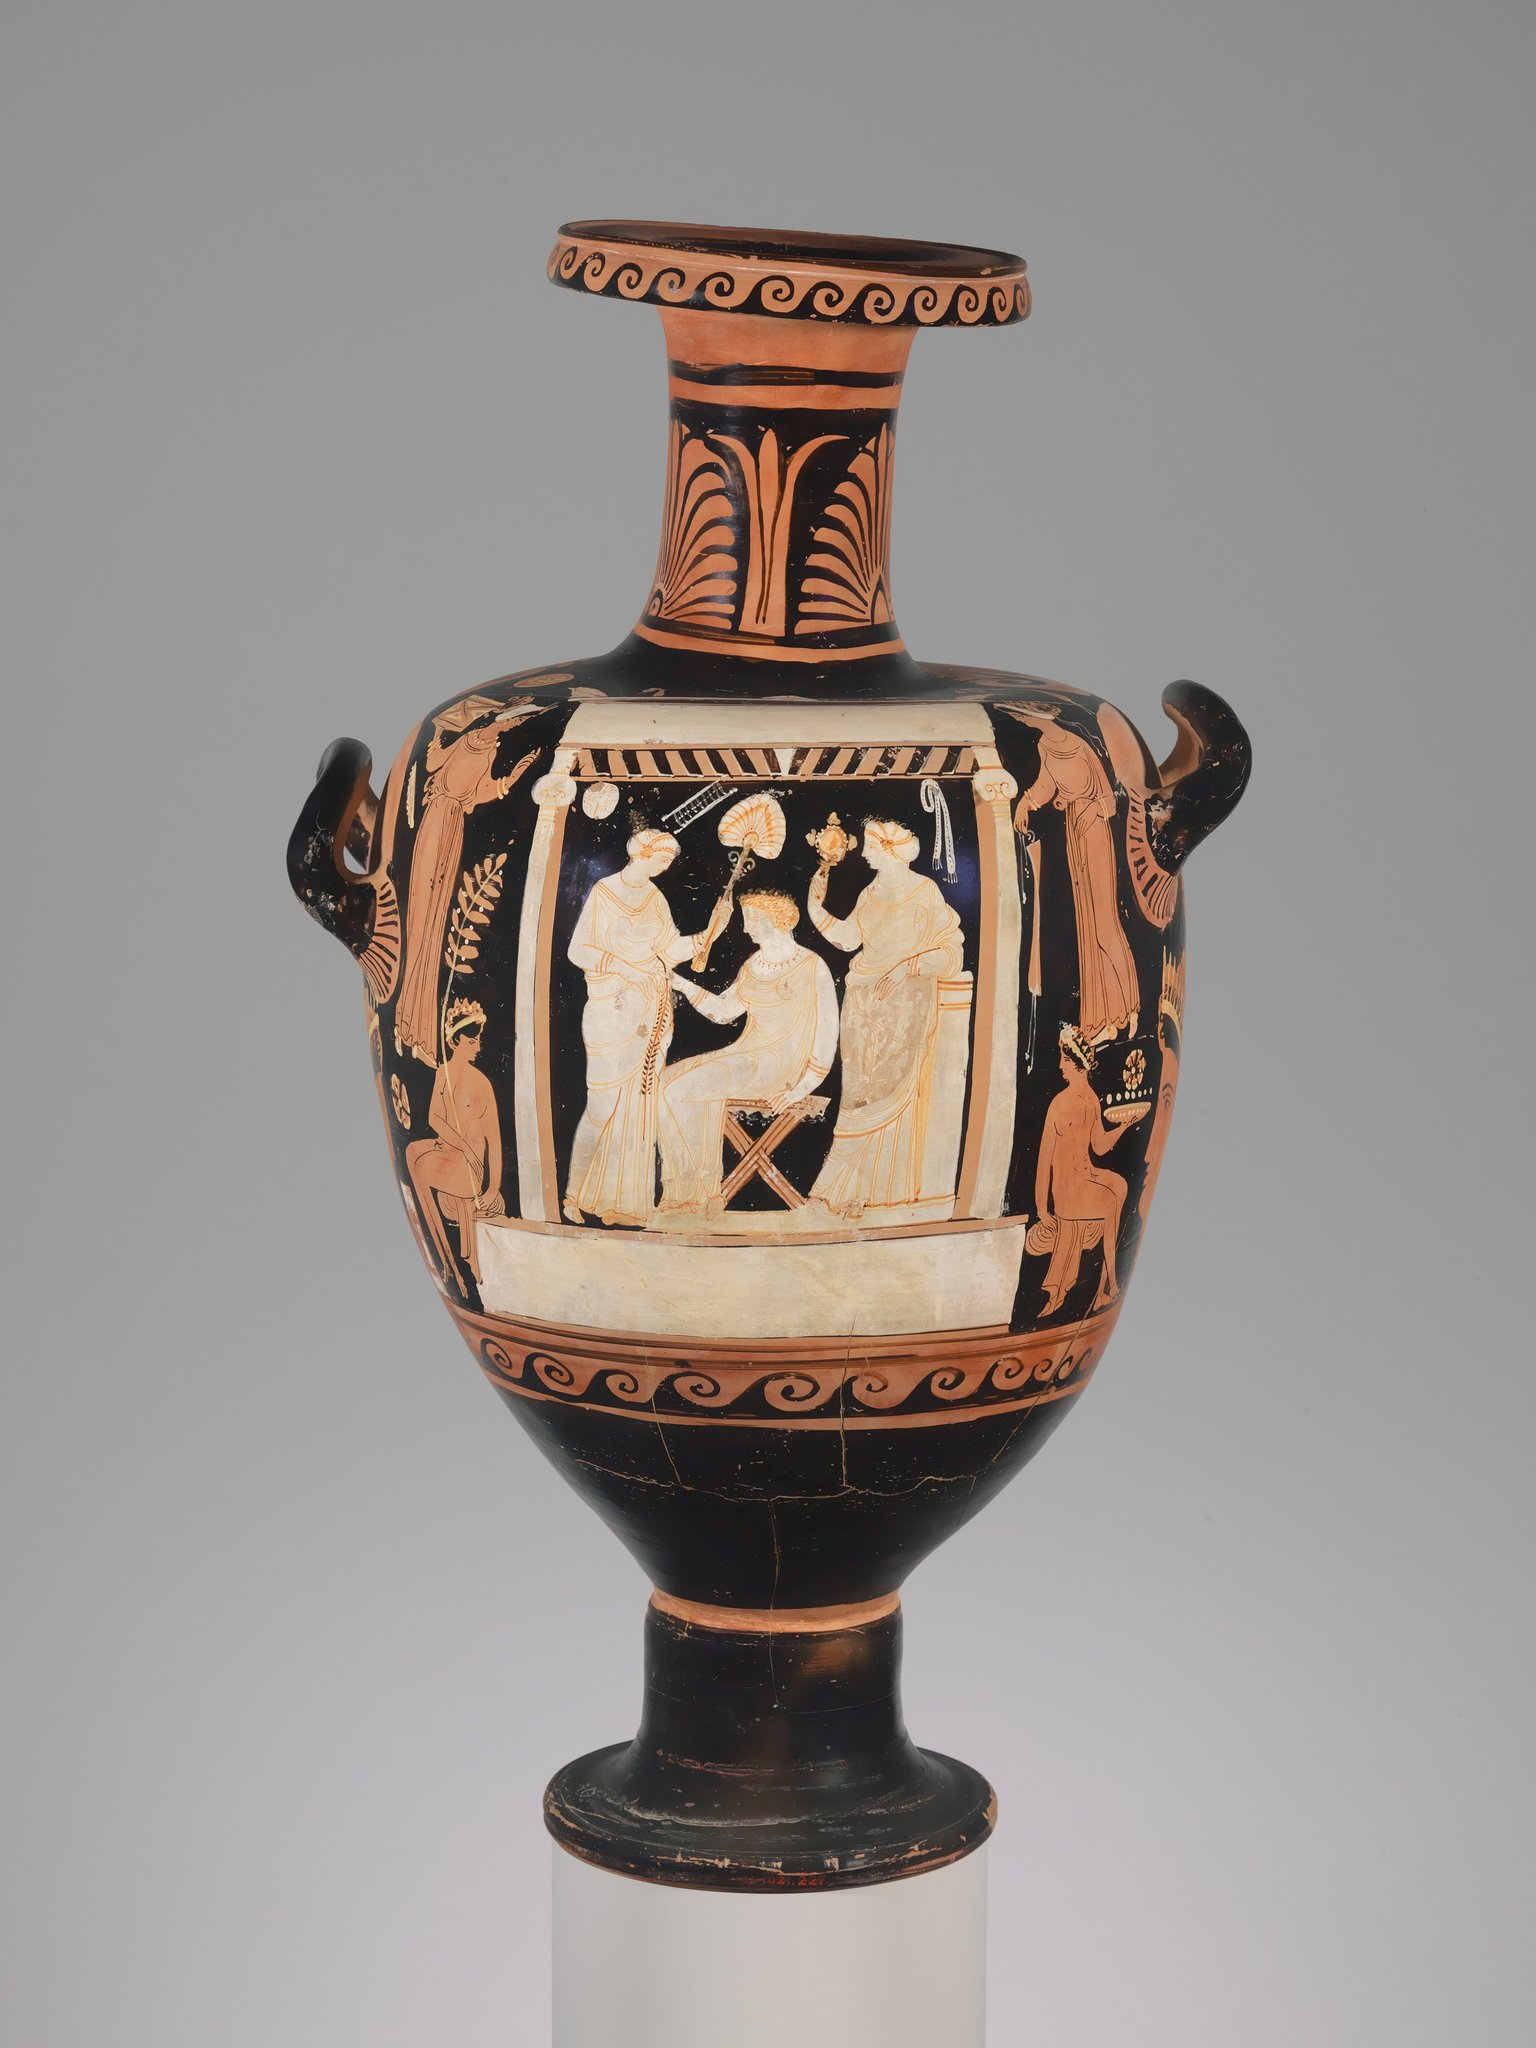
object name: hydria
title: Terracotta hydria (water jar)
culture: greek or south italian or campanian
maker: apz painter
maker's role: artist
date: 330-300 BCE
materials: terracotta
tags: women